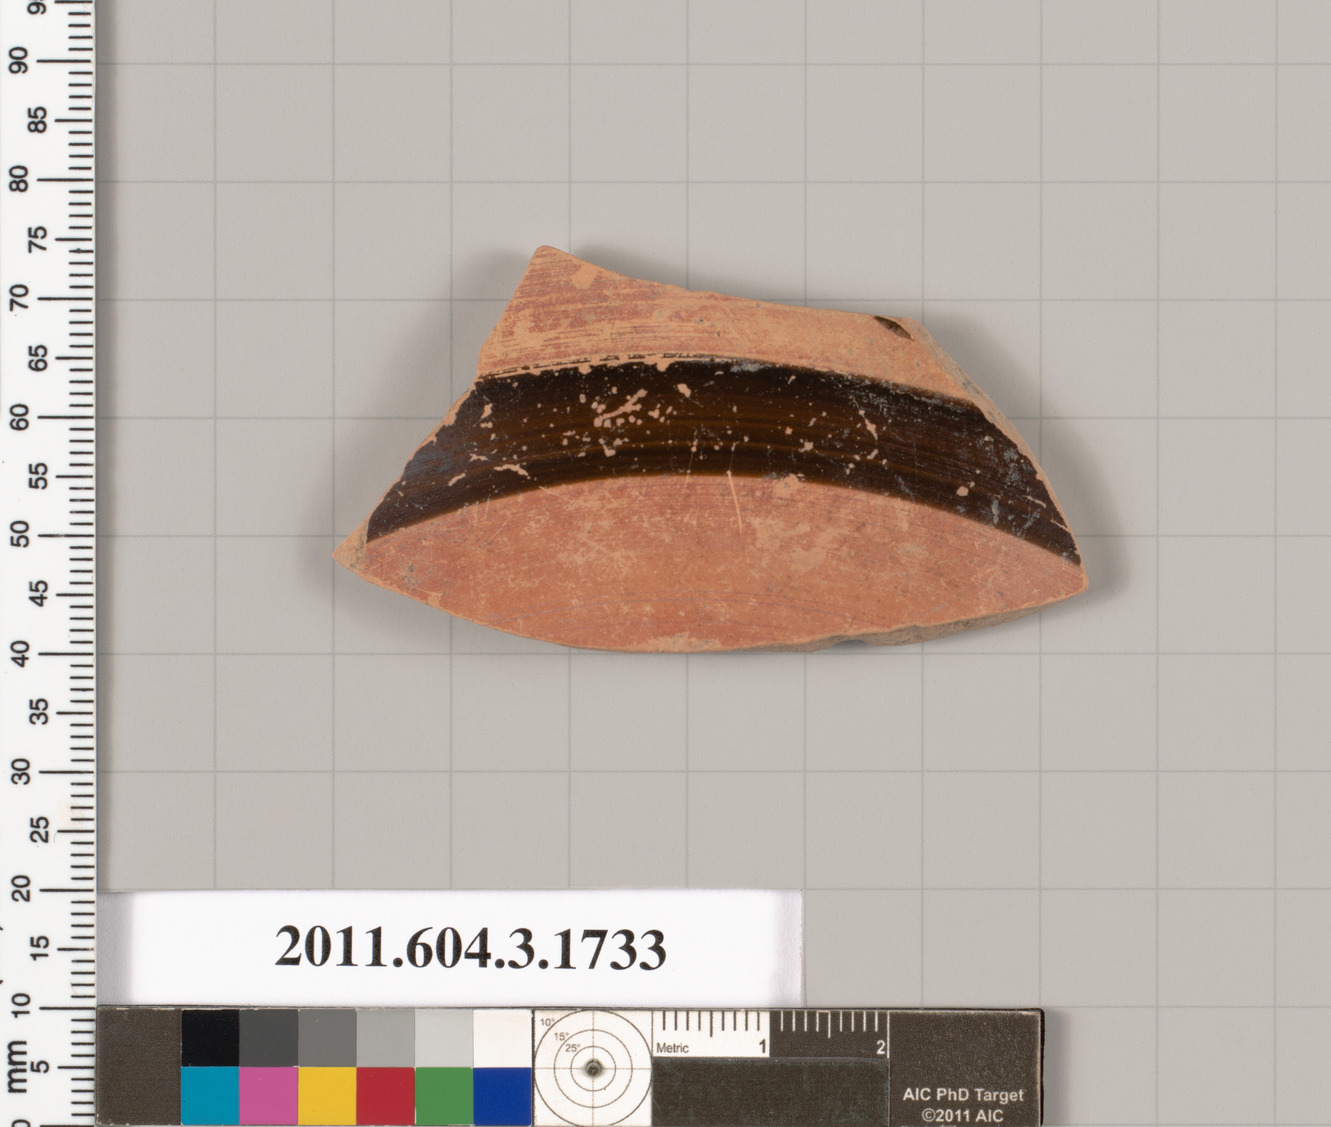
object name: kylix fragment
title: Terracotta fragment of a kylix: Band or lip cup (drinking cup)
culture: greek, attic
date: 550-526 BCE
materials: terracotta